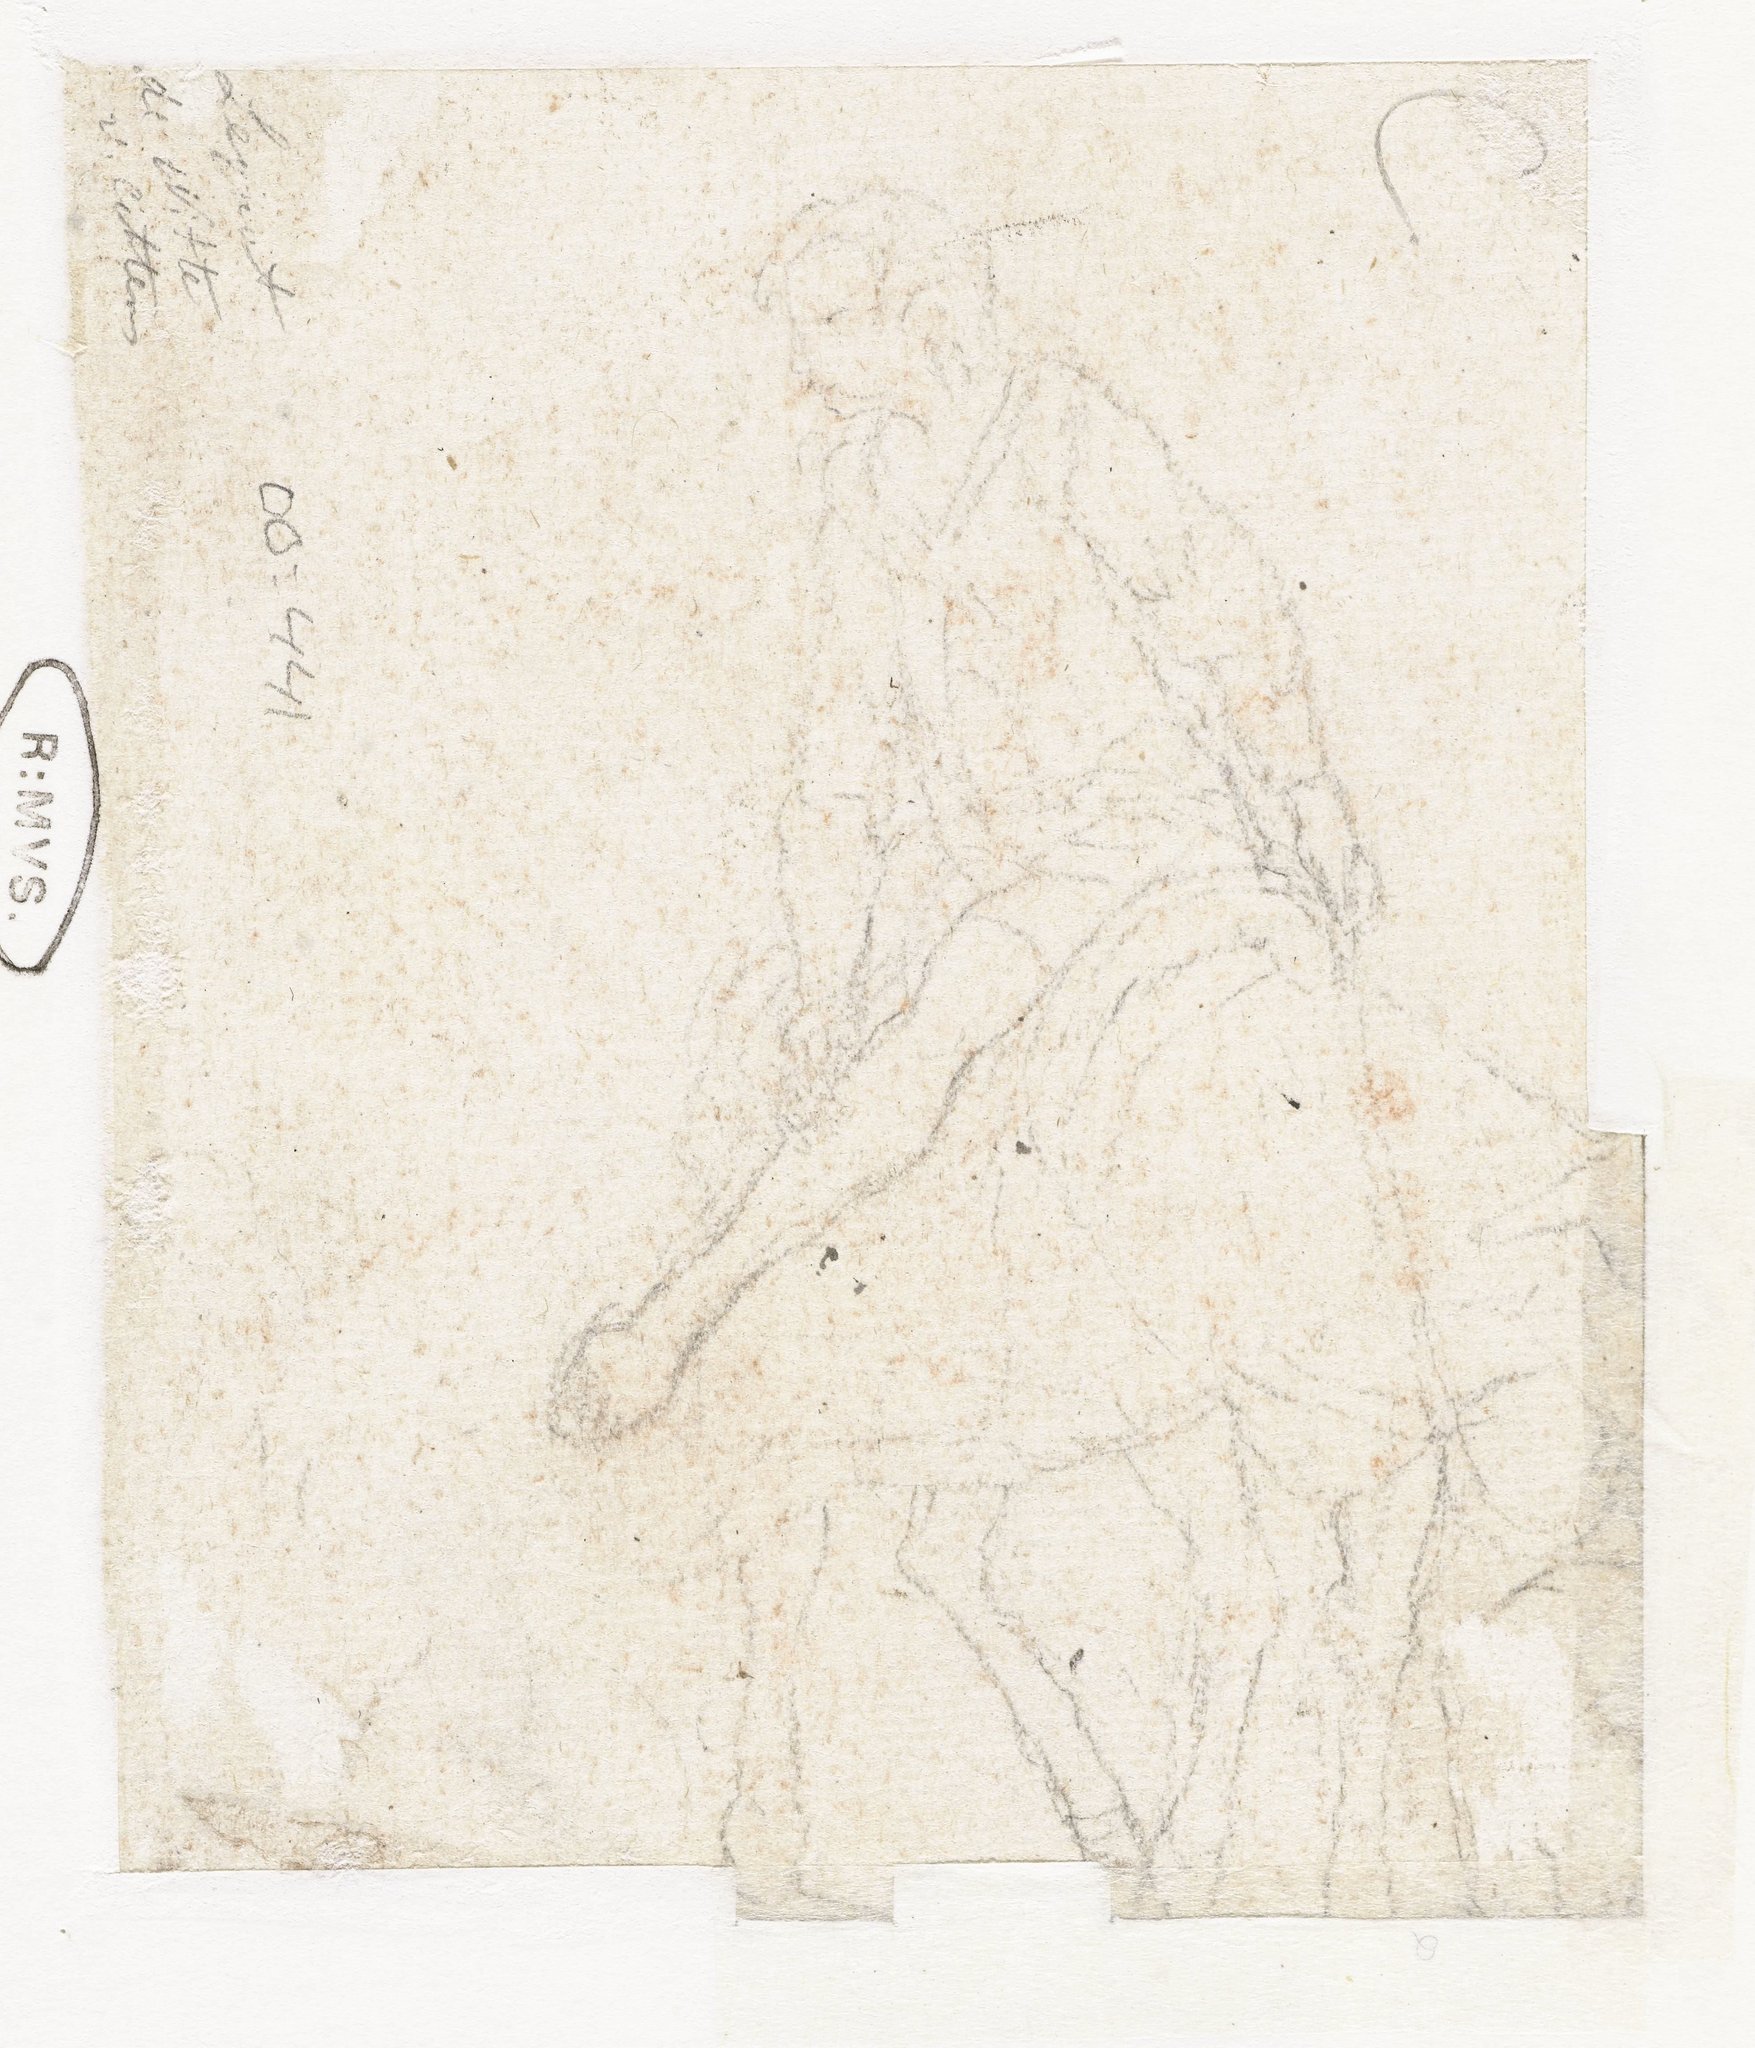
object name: drawing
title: Schets van een man op een ezel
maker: peter paul rubens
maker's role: draughtsman, painter, print maker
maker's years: 1577-1640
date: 1650-1690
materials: chalk, paper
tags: riding a horse, ass, or mule; rider, horseman, ass, donkey